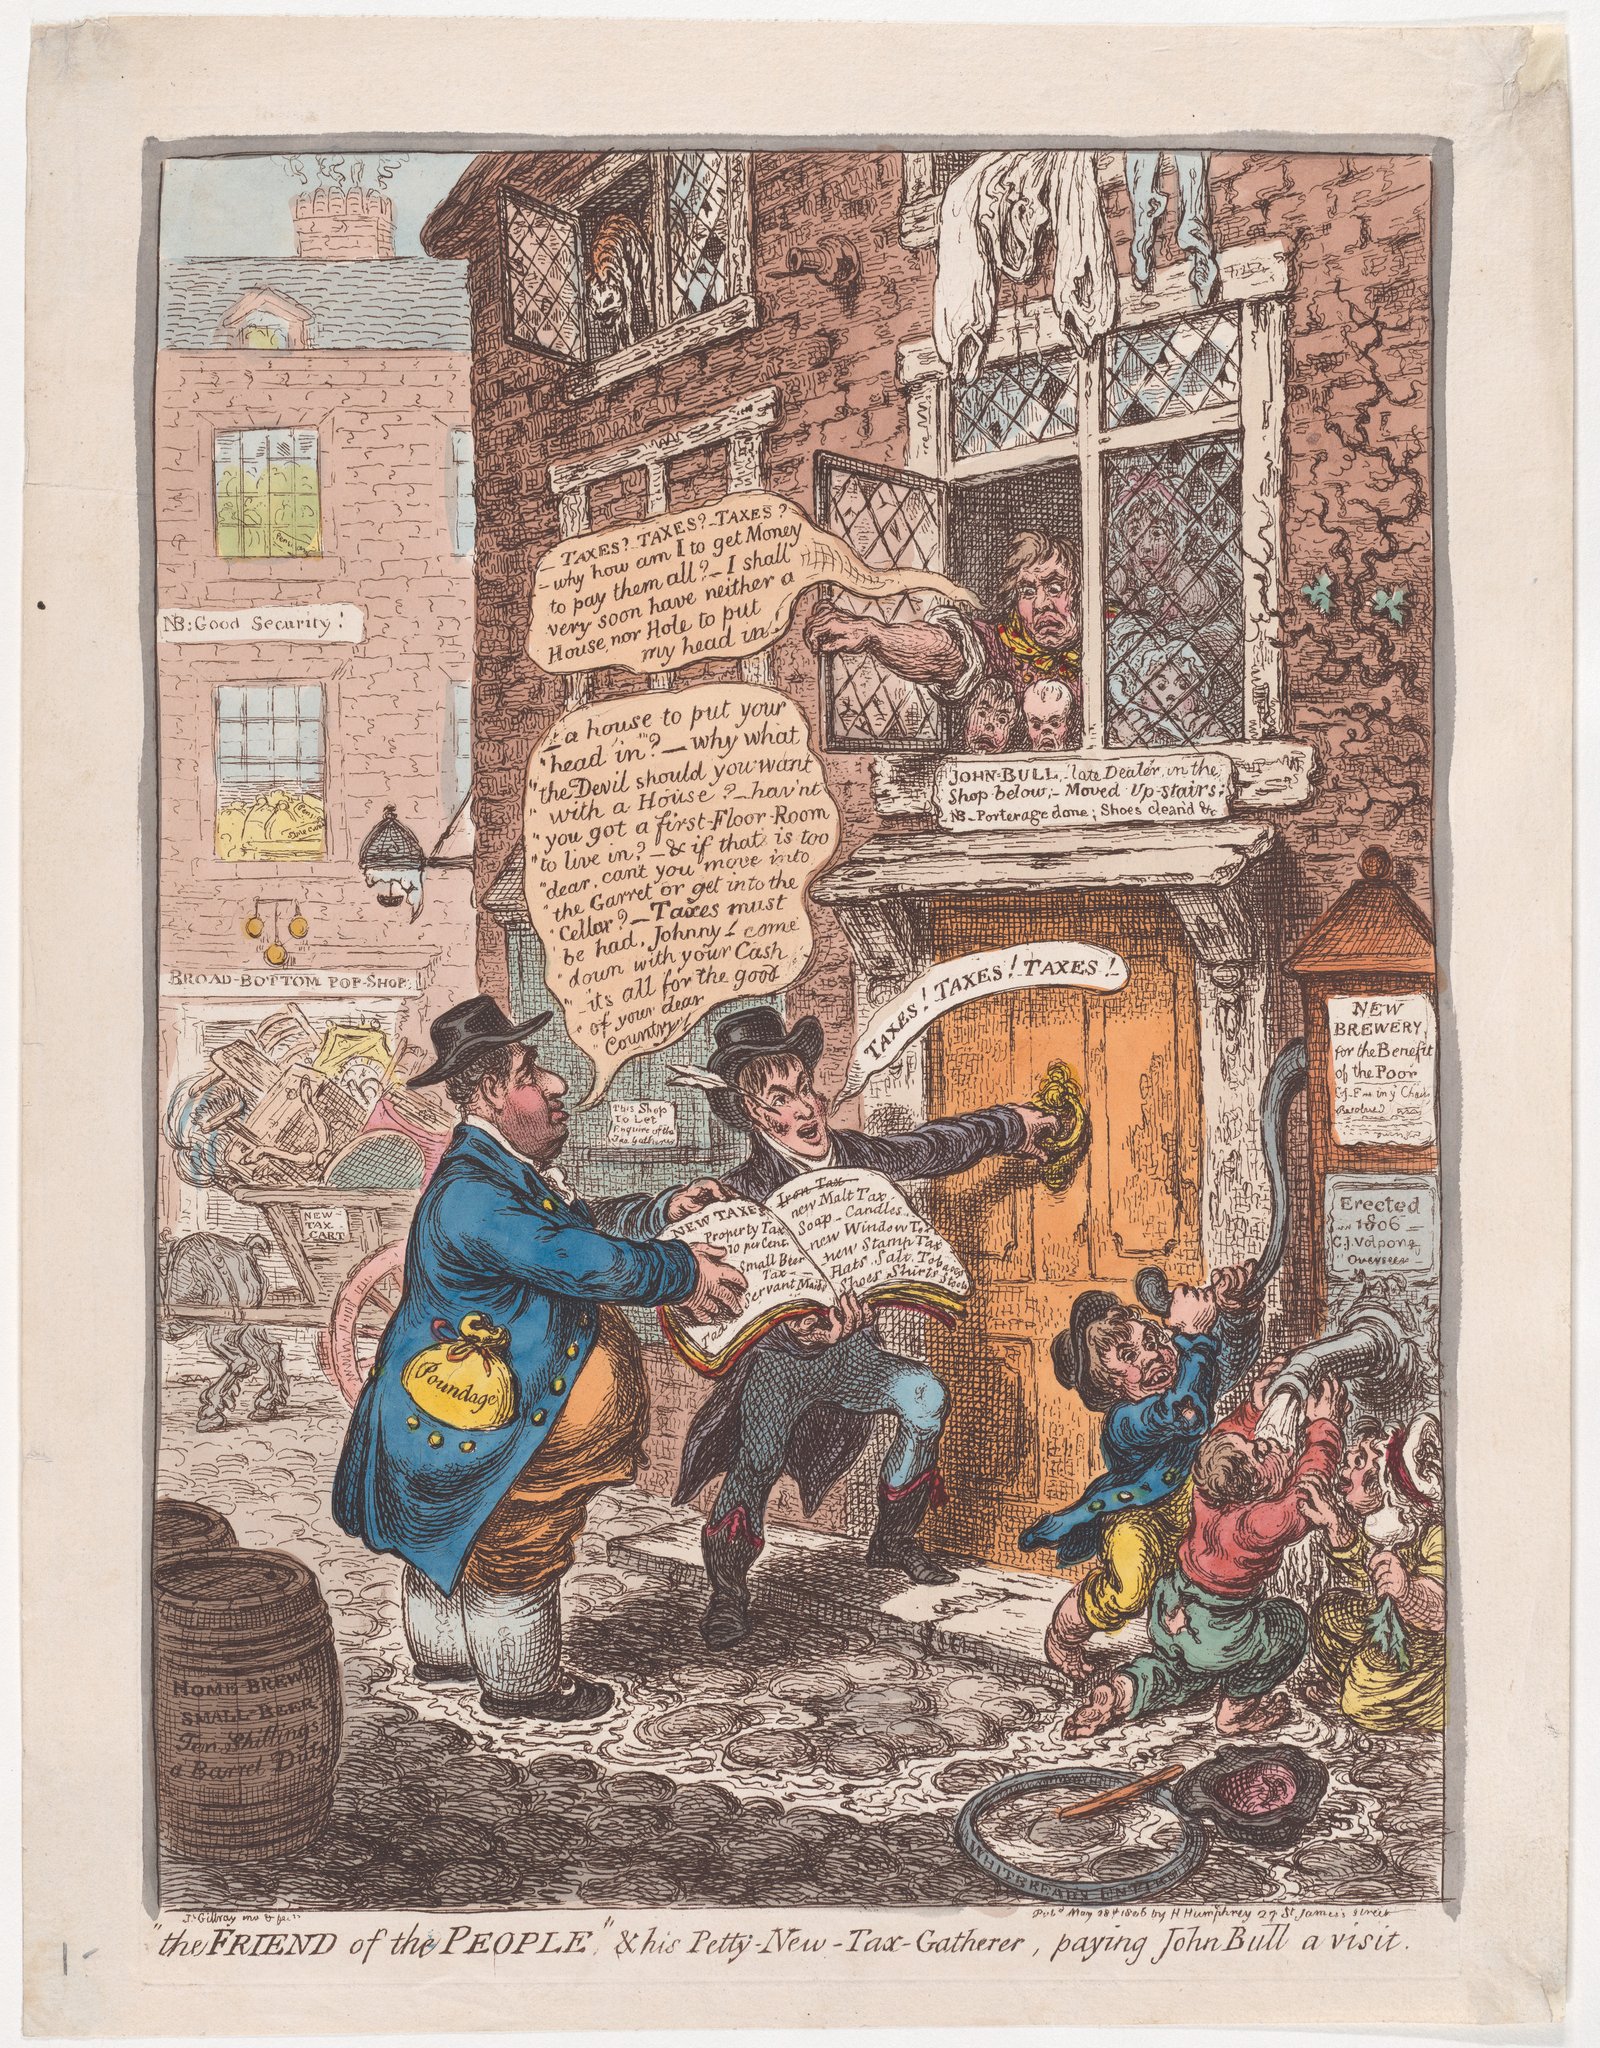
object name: print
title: "The Friend of the People" & his Petty New Tax Gatherer, Paying John Bull a Visit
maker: james gillray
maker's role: artist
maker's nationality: british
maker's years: 1756-1815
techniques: etching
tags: satire,men,caricature,politics